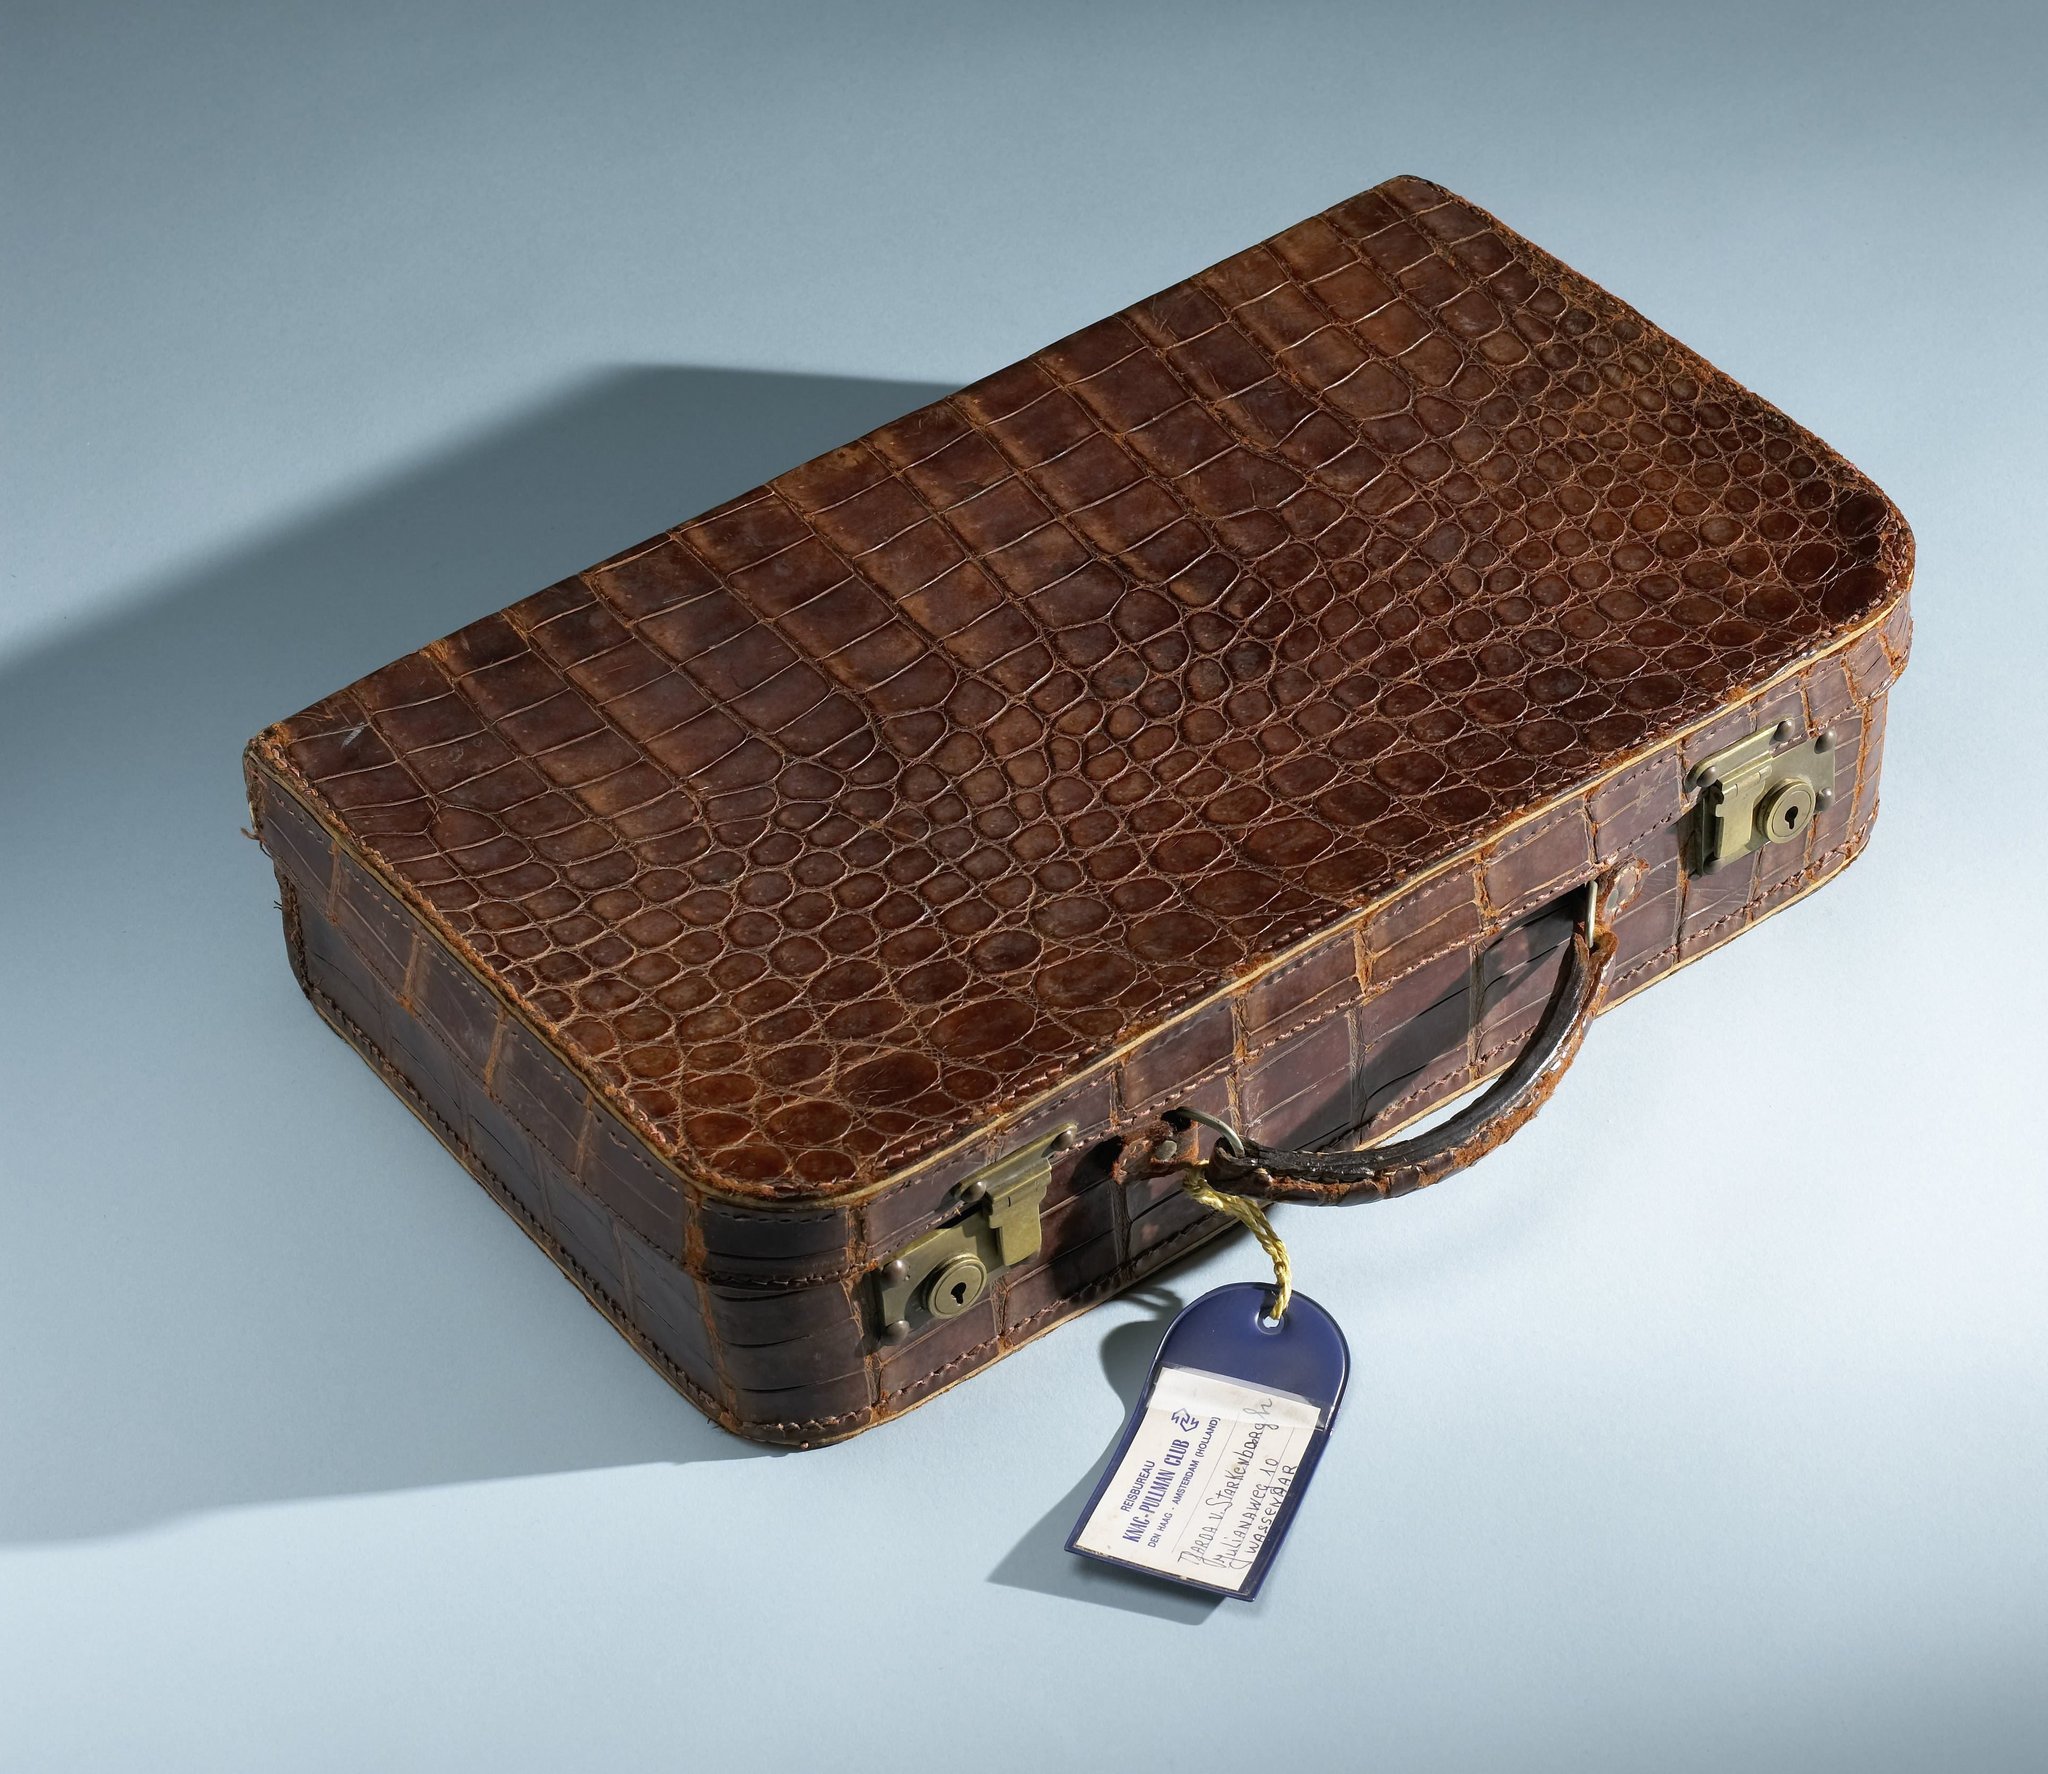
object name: suitcase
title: Koffertje van Jonkheer Mr. Dr. A.W.L. Tjarda van Starkenborch Stachouwer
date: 1935-1940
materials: cardboard, leather, linen, metal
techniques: sewing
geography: jakarta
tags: politician, dutch east indies, the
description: Koffertje van Jonkheer Mr. Dr. A.W.L. Tjarda van Starkenborch Stachouwer, door hem meegedragen tijdens zijn internering in Japanse kampen. Krokodillenleren koffertje met stoffen binnenwerk met koperen of messing dubbele sluiting. Plastic adreslabel aan geel touwtje met opschrift: 'Tjarda van Starkenborch, Julianaweg 10, Wassenaar'. Het koffertje bevatte papieren, sleutels en spullen behorend bij zijn functie.